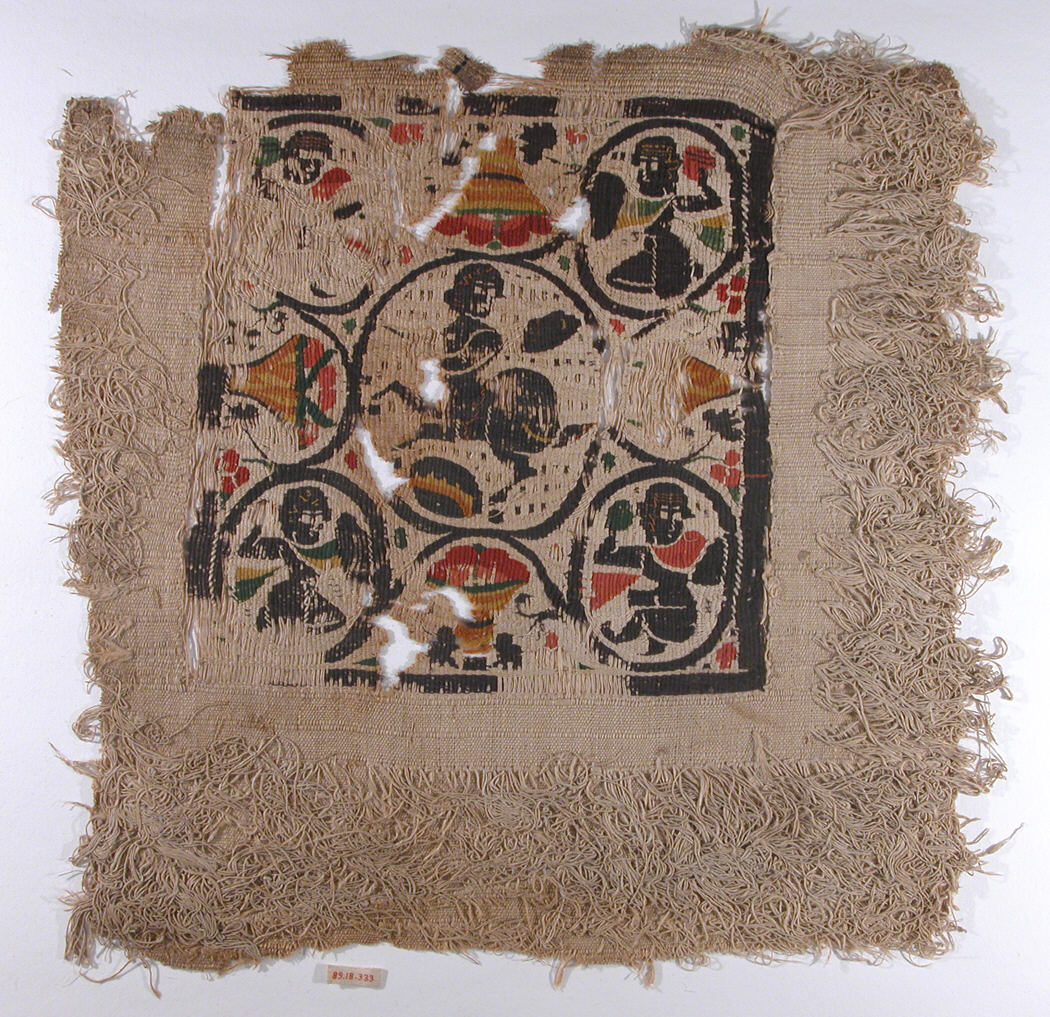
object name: textile fragment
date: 301-400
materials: linen, wool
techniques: weave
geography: egypt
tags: human figures